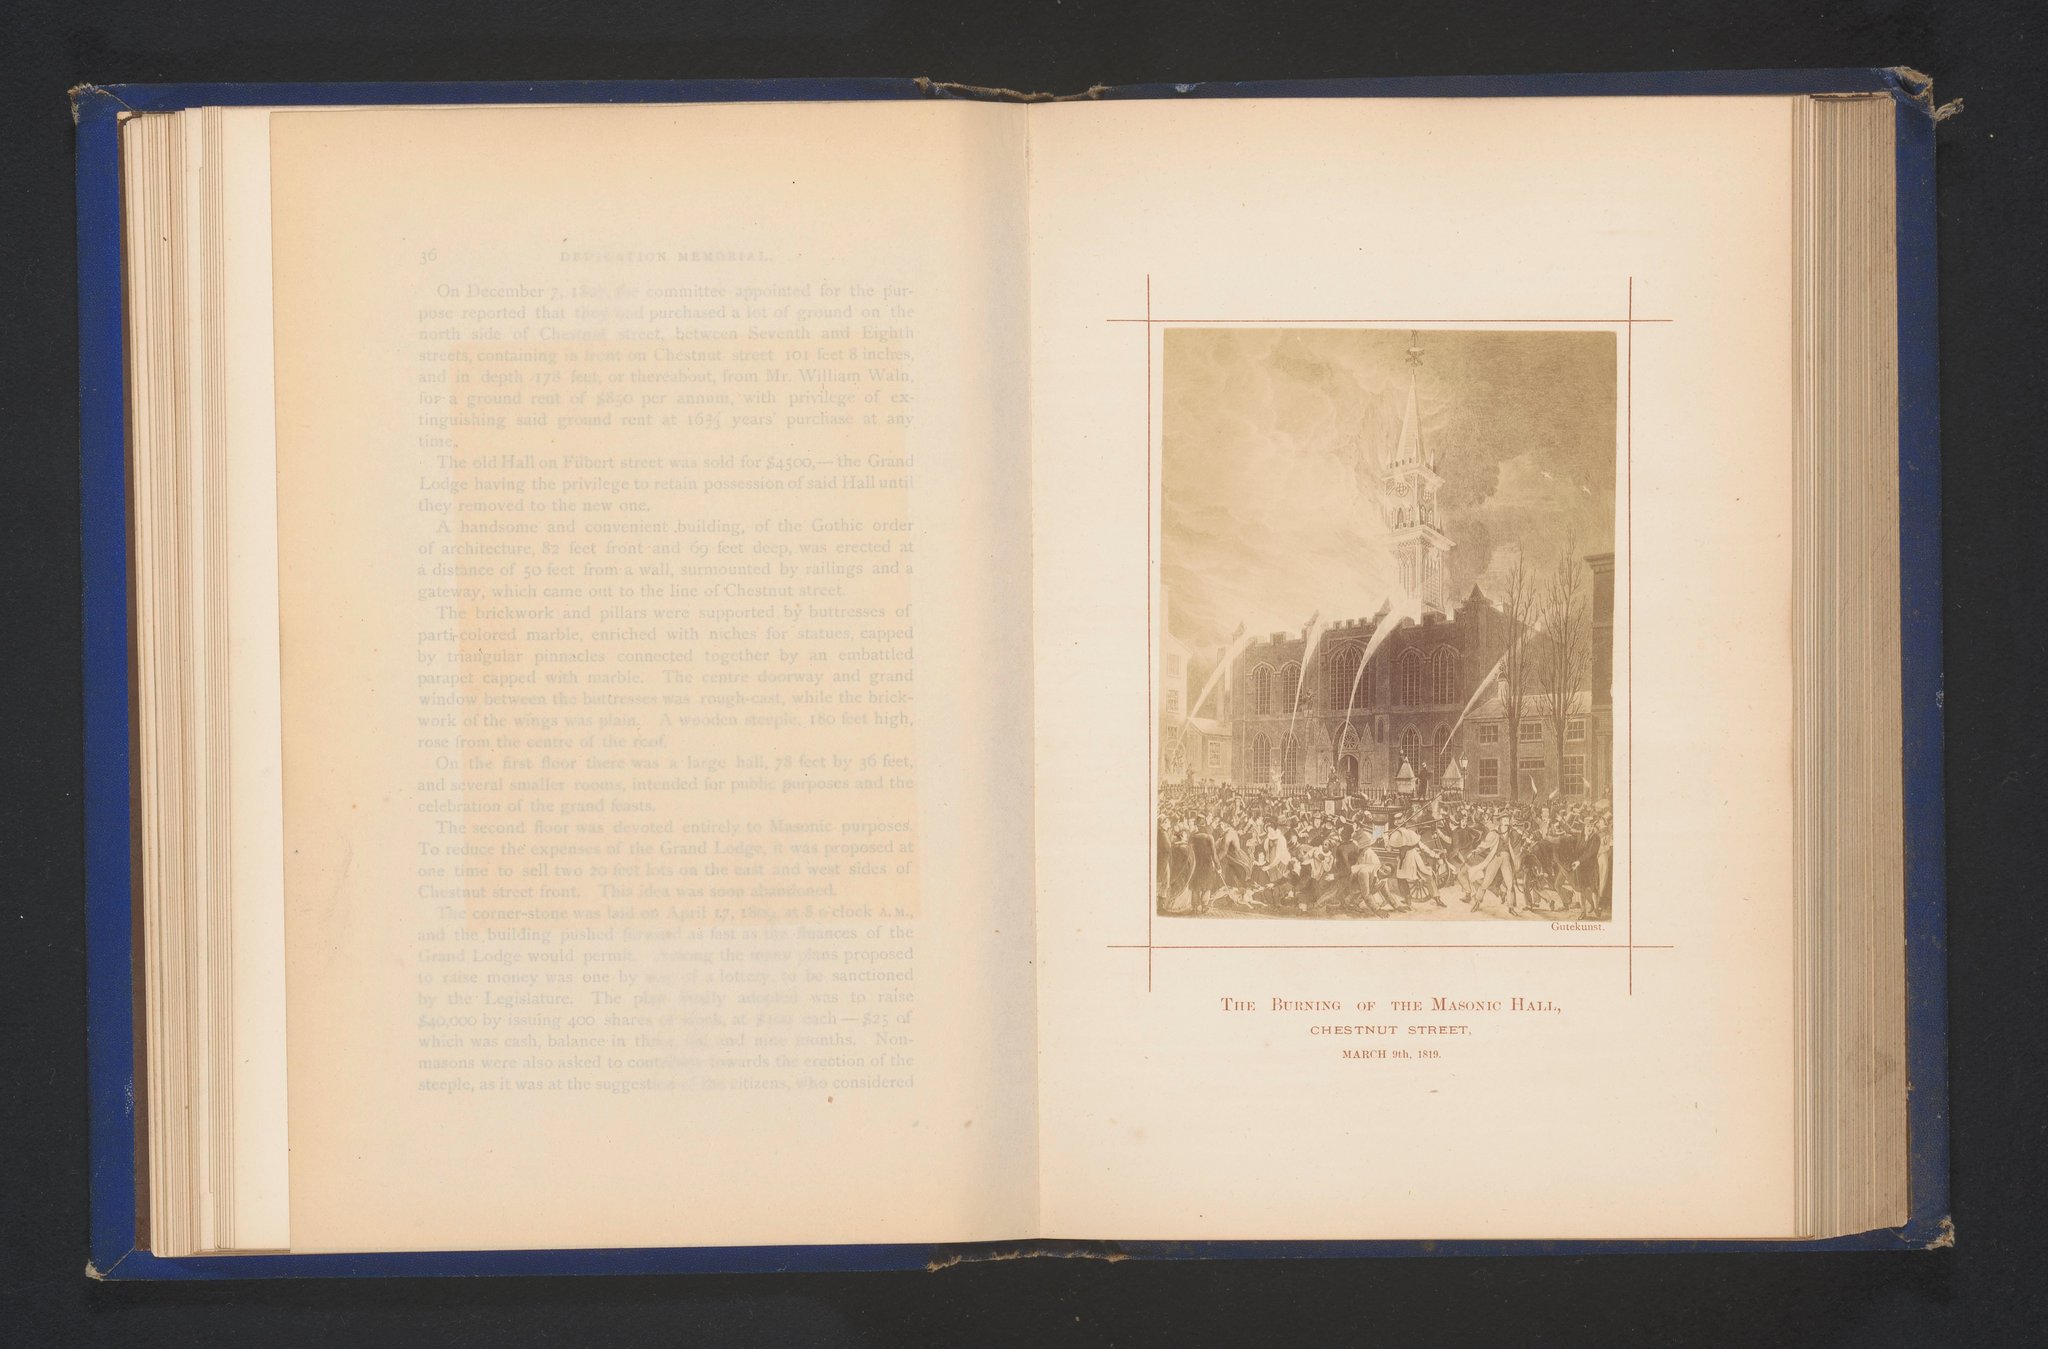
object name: reproduction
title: The burning of the Masonic hall, Chestnut Street, March 9th, 1819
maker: frederick gutekunst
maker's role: fotograaf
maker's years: 1831-1917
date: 1869-1874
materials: photographic support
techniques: albumen print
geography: philadelphia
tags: extinguishing a fire, miscellaneous religions, cults and doctrines: freemasonry, façade (of house or building)